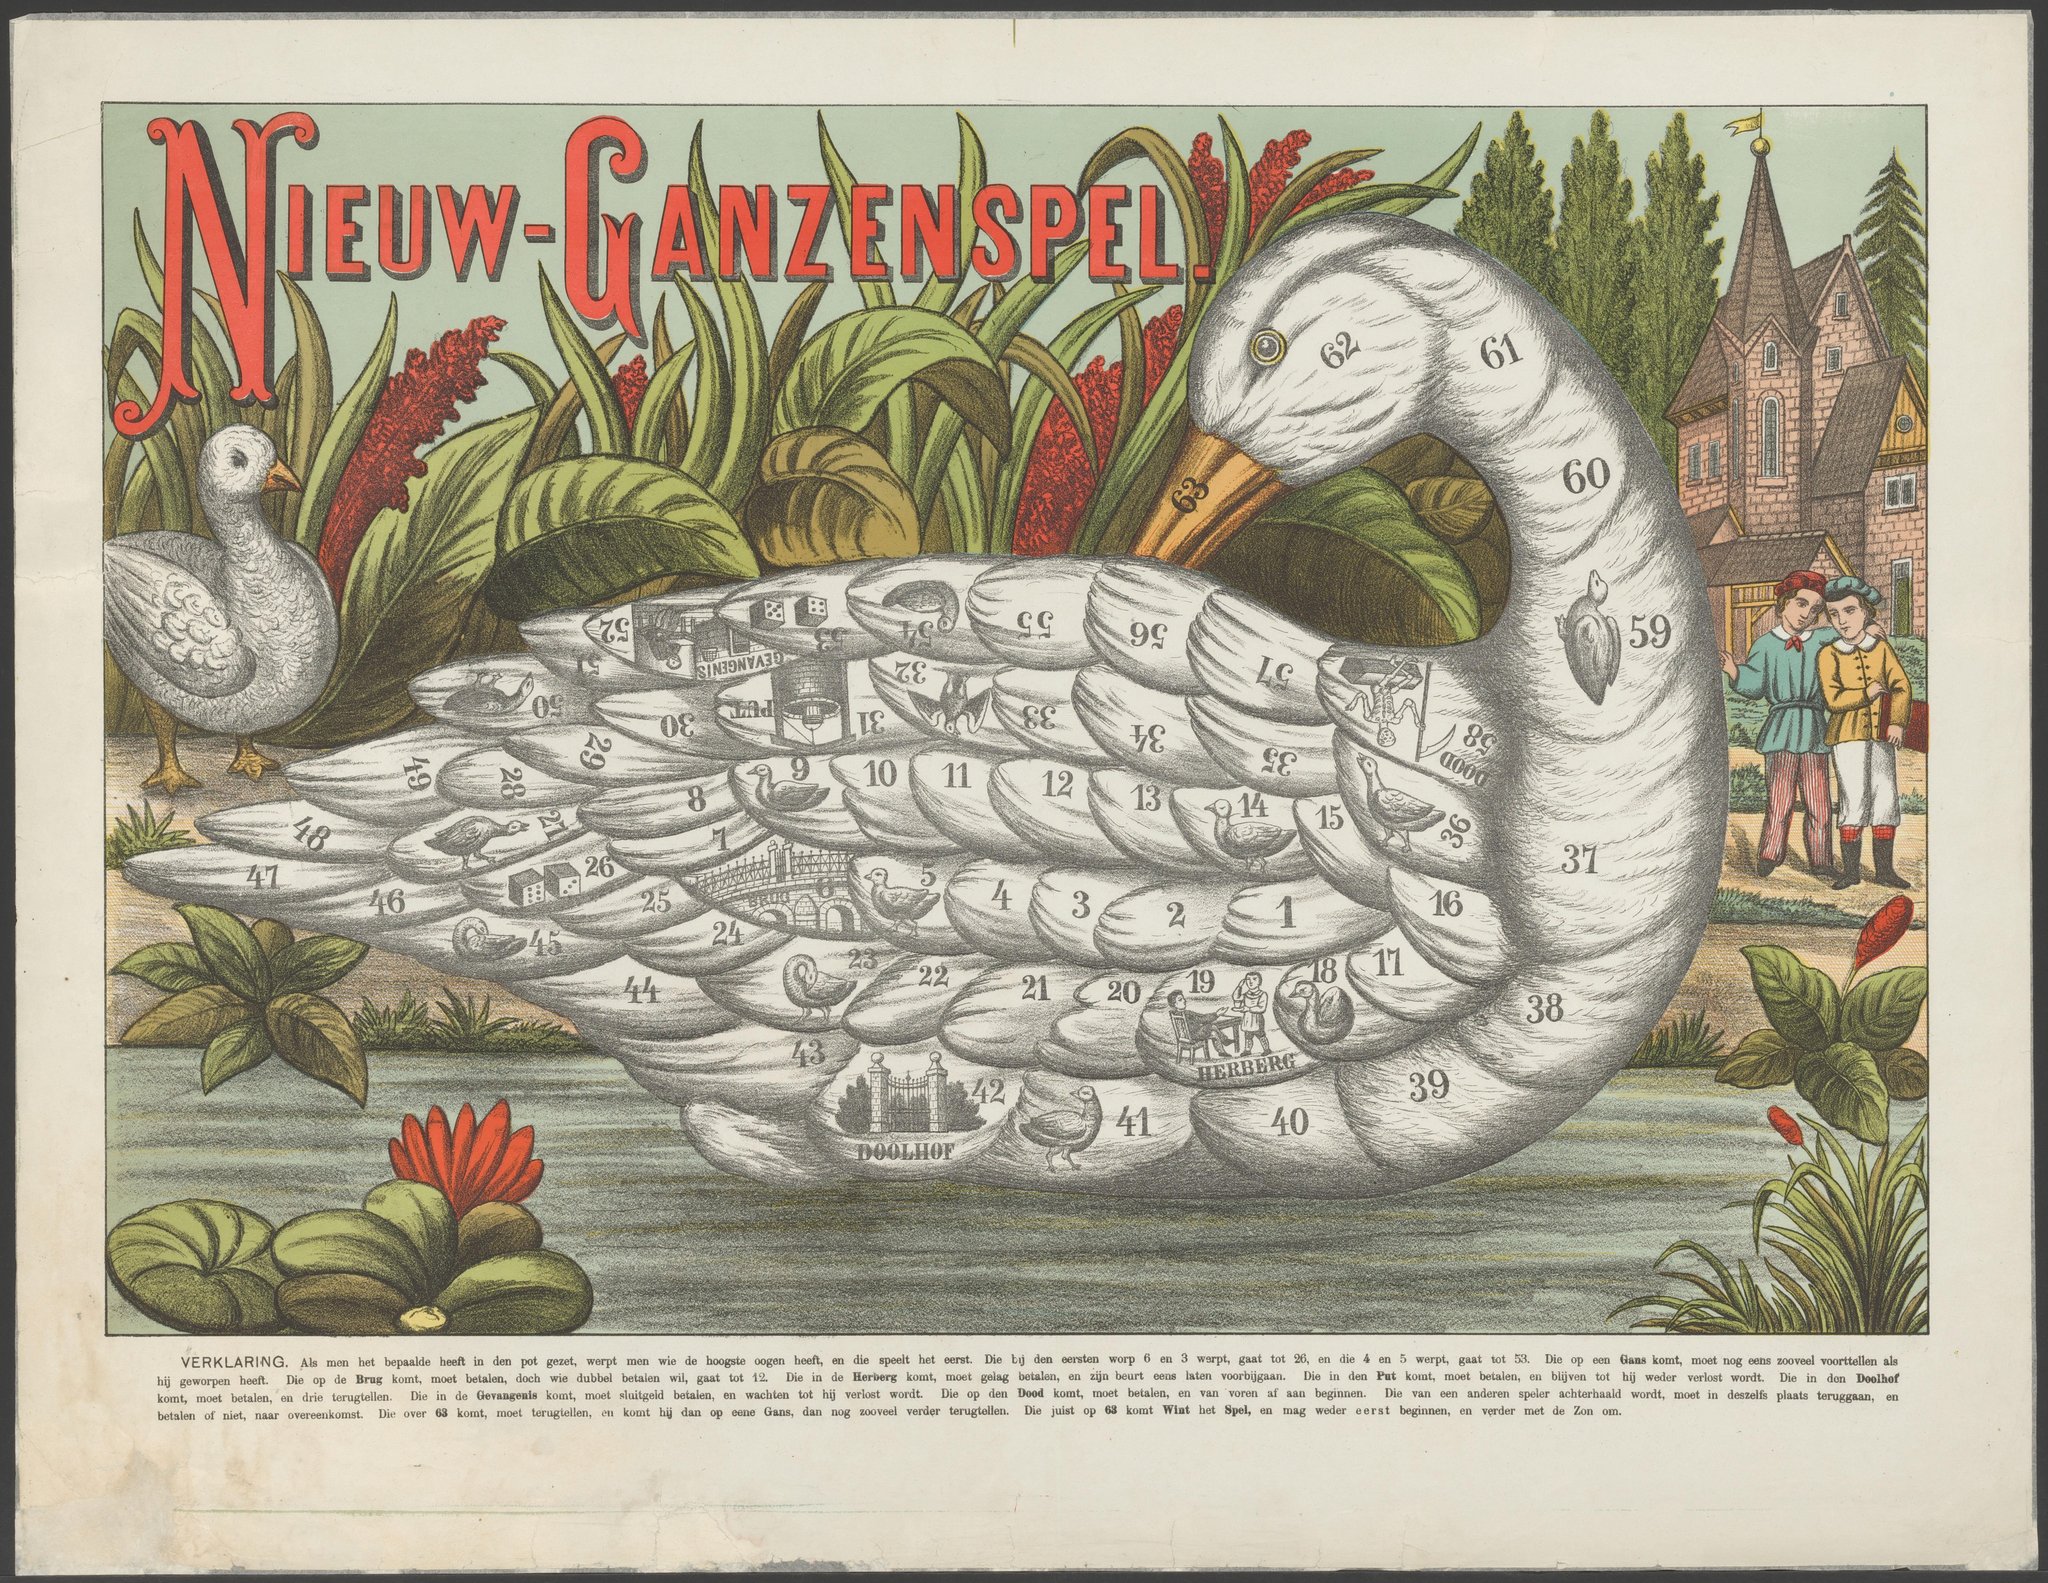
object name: print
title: Nieuw-Ganzenspel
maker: Anonymous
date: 1850-1899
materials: paper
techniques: lithograph, letterpress printing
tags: goose-game, board-games of chance, board-games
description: Ganzenbord in de vorm van een zwemmende gans met 63 vakken op de veren en de snavel. Achter de gans op de waterkant planten en een ganzenjong. Rechts twee jongens bij een landhuis. Onder het spel de spelregels. Onderwerpsrubrieken binnen de Atlas Zeden en Gewoonten: Zeden en gewoonten in engeren zin, Spel en vermaak, Gezelschapsspel II, Ganzenbord en dergelijke.